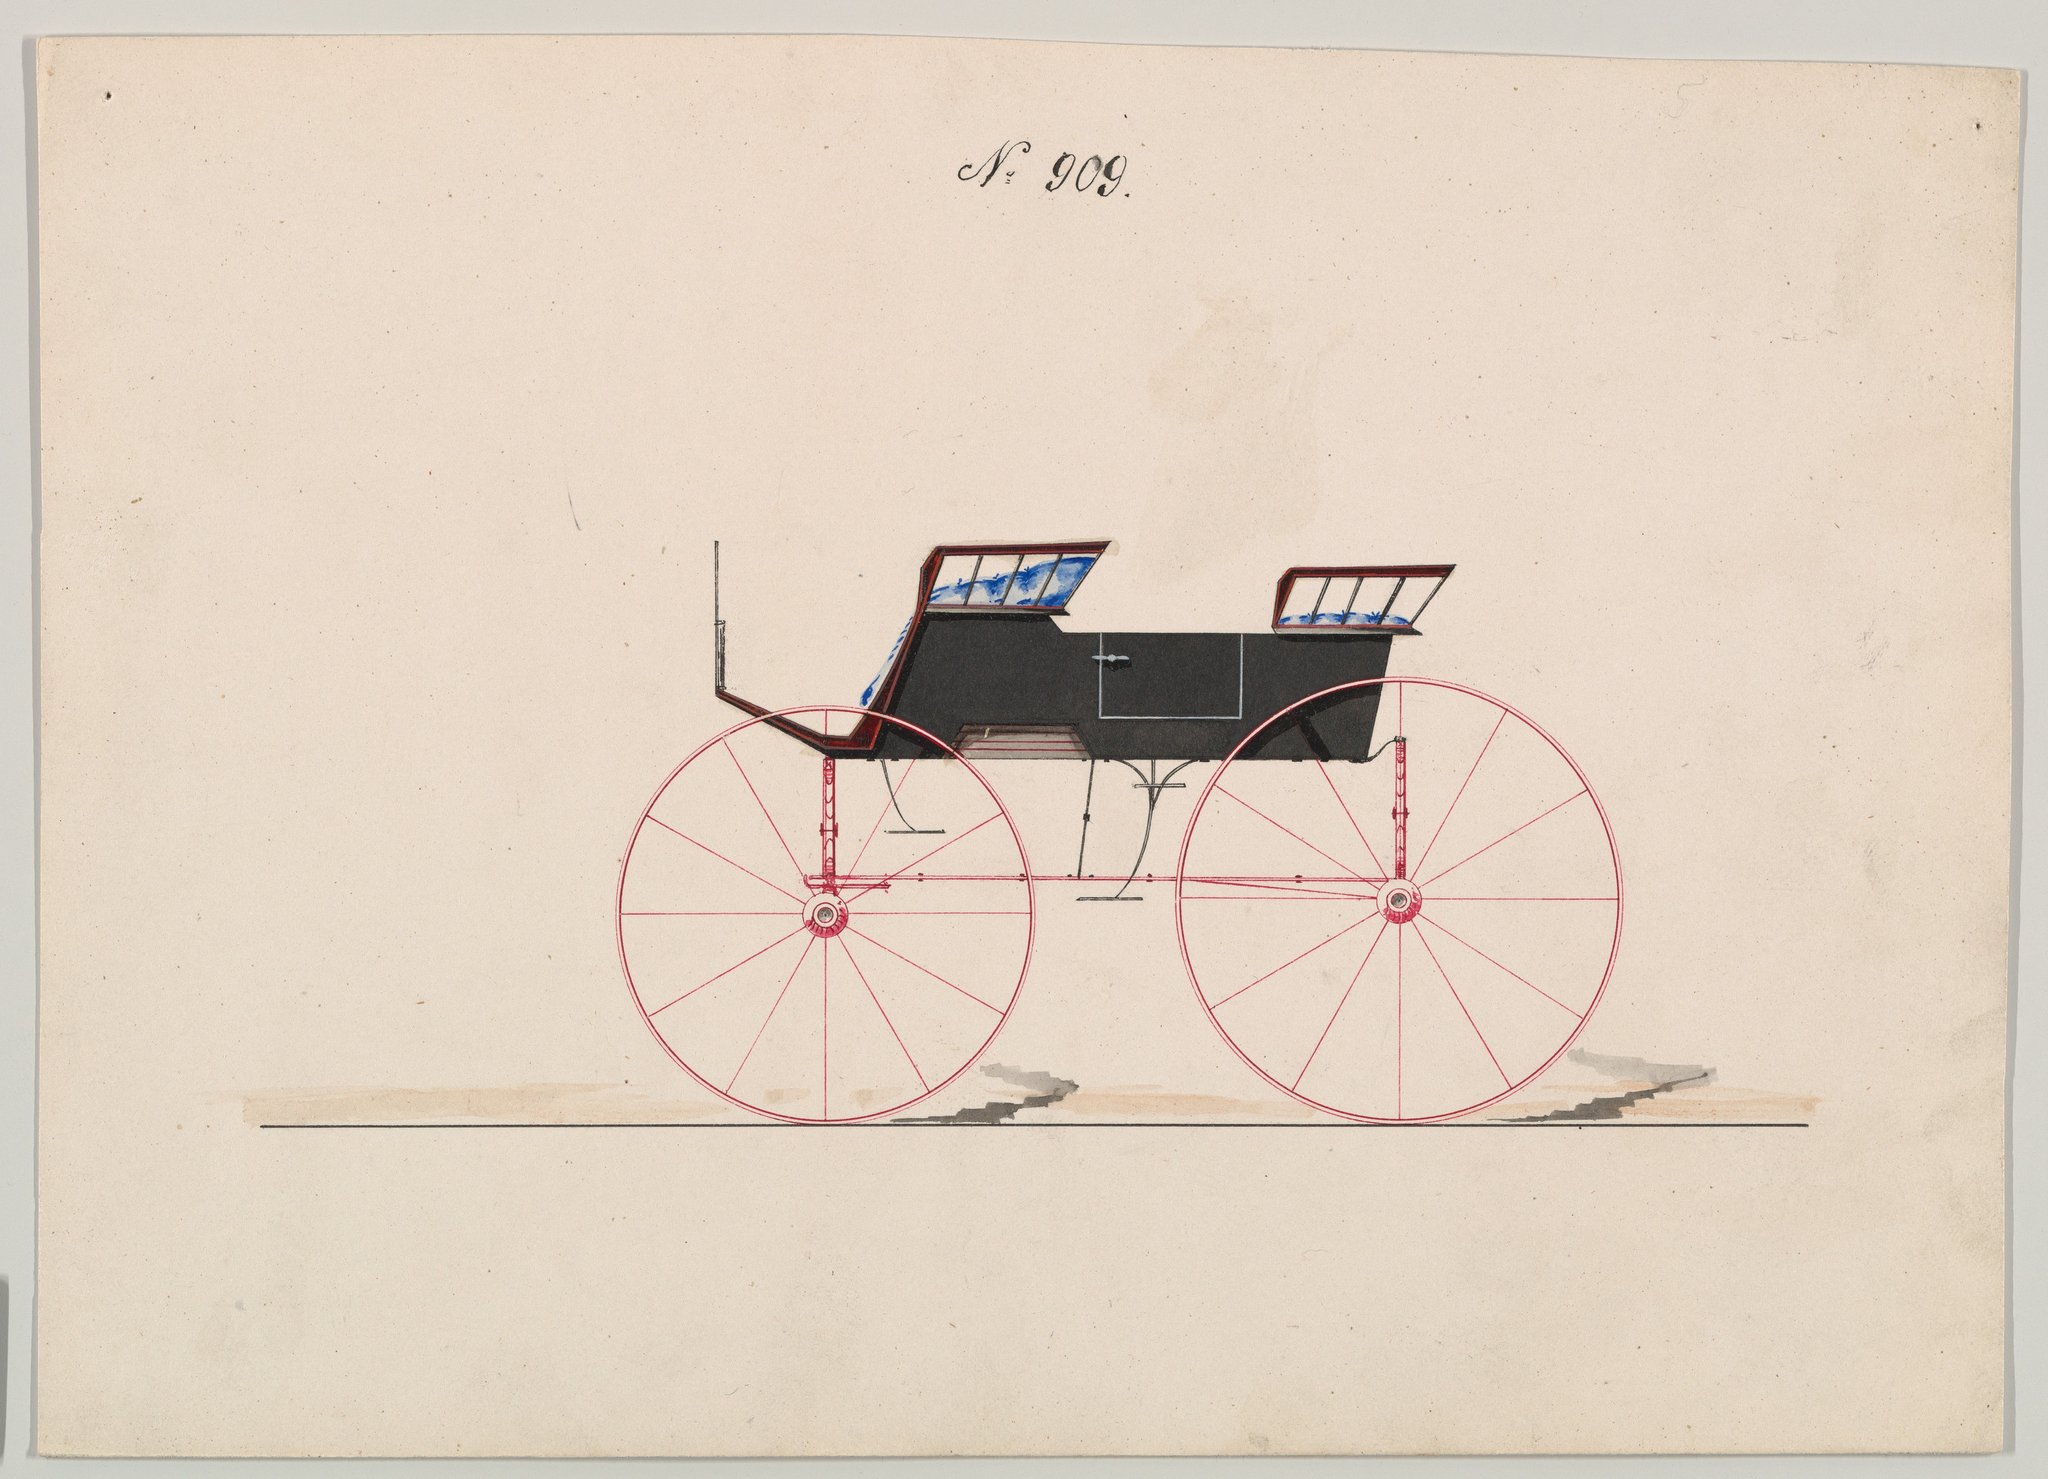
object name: drawing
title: Design for Wagon, no. 909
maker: brewster & co.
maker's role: manufacturer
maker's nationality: american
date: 1870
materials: gouache, gum arabic, ink, watercolor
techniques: pen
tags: carriages